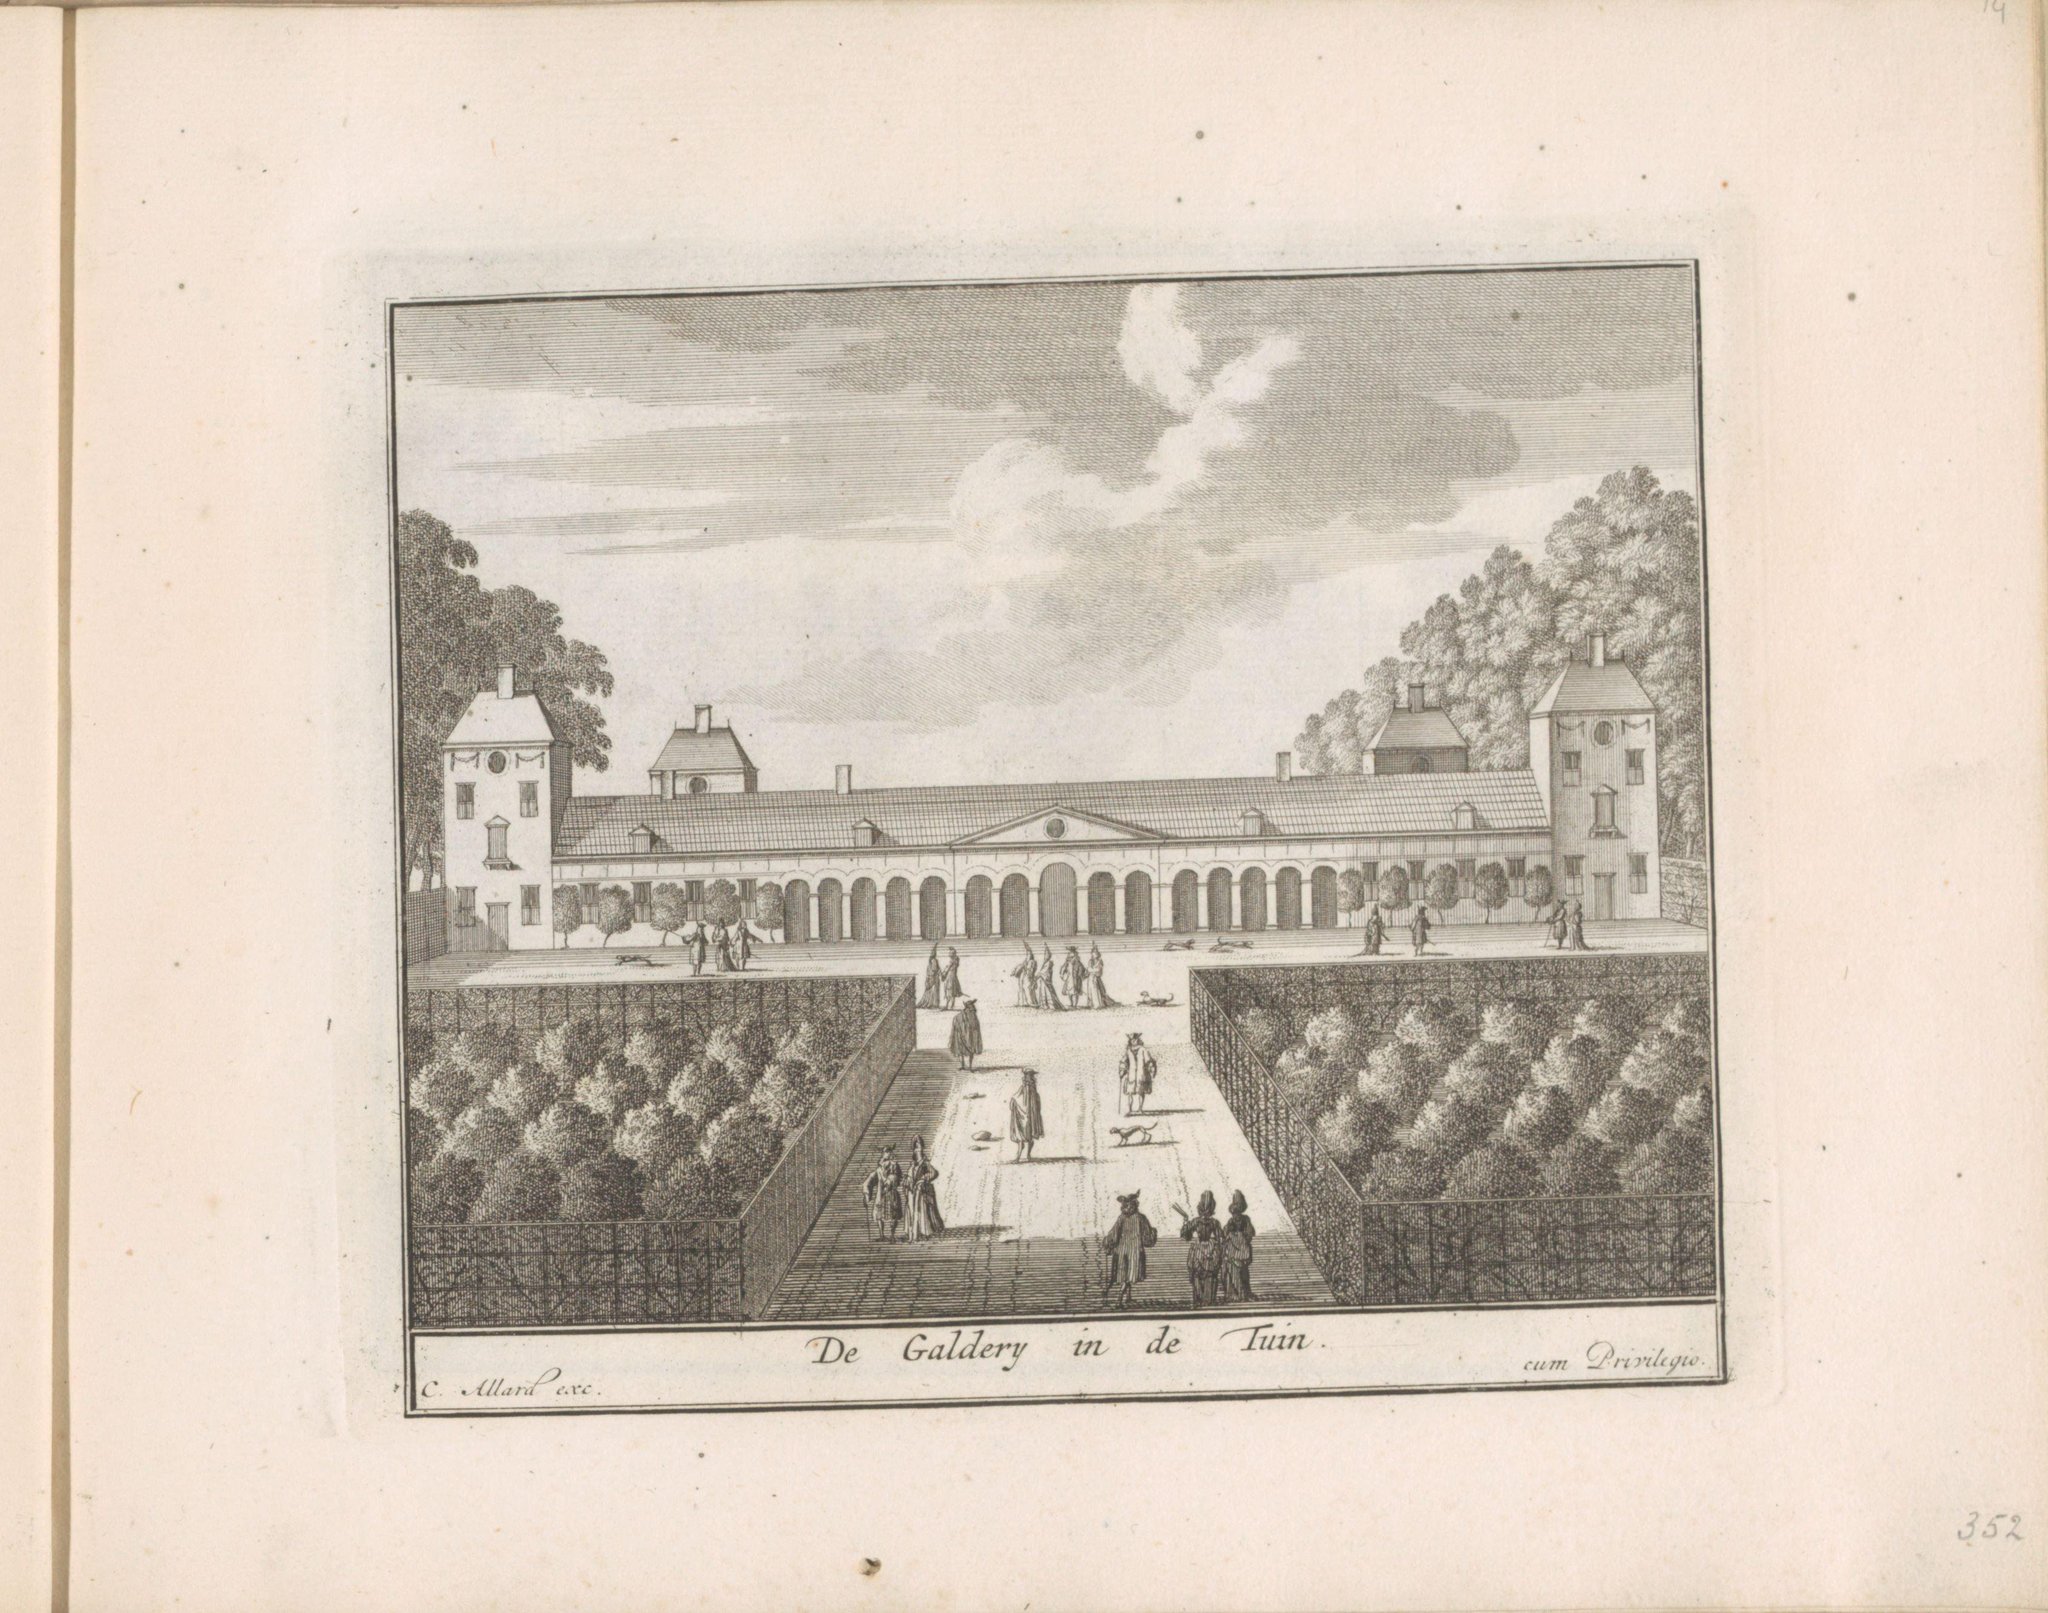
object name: print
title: Galerij in de tuin van Paleis Honselaarsdijk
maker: carel allard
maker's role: print maker, publisher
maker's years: 1648-1709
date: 1689-1702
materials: paper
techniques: etching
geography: amsterdam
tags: palace, french or architectonic garden; formal garden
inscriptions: number: ‘352’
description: Parklandschap met galerij, op de lanen flaneren groepjes wandelaars. Prent maakt deel uit van een album.